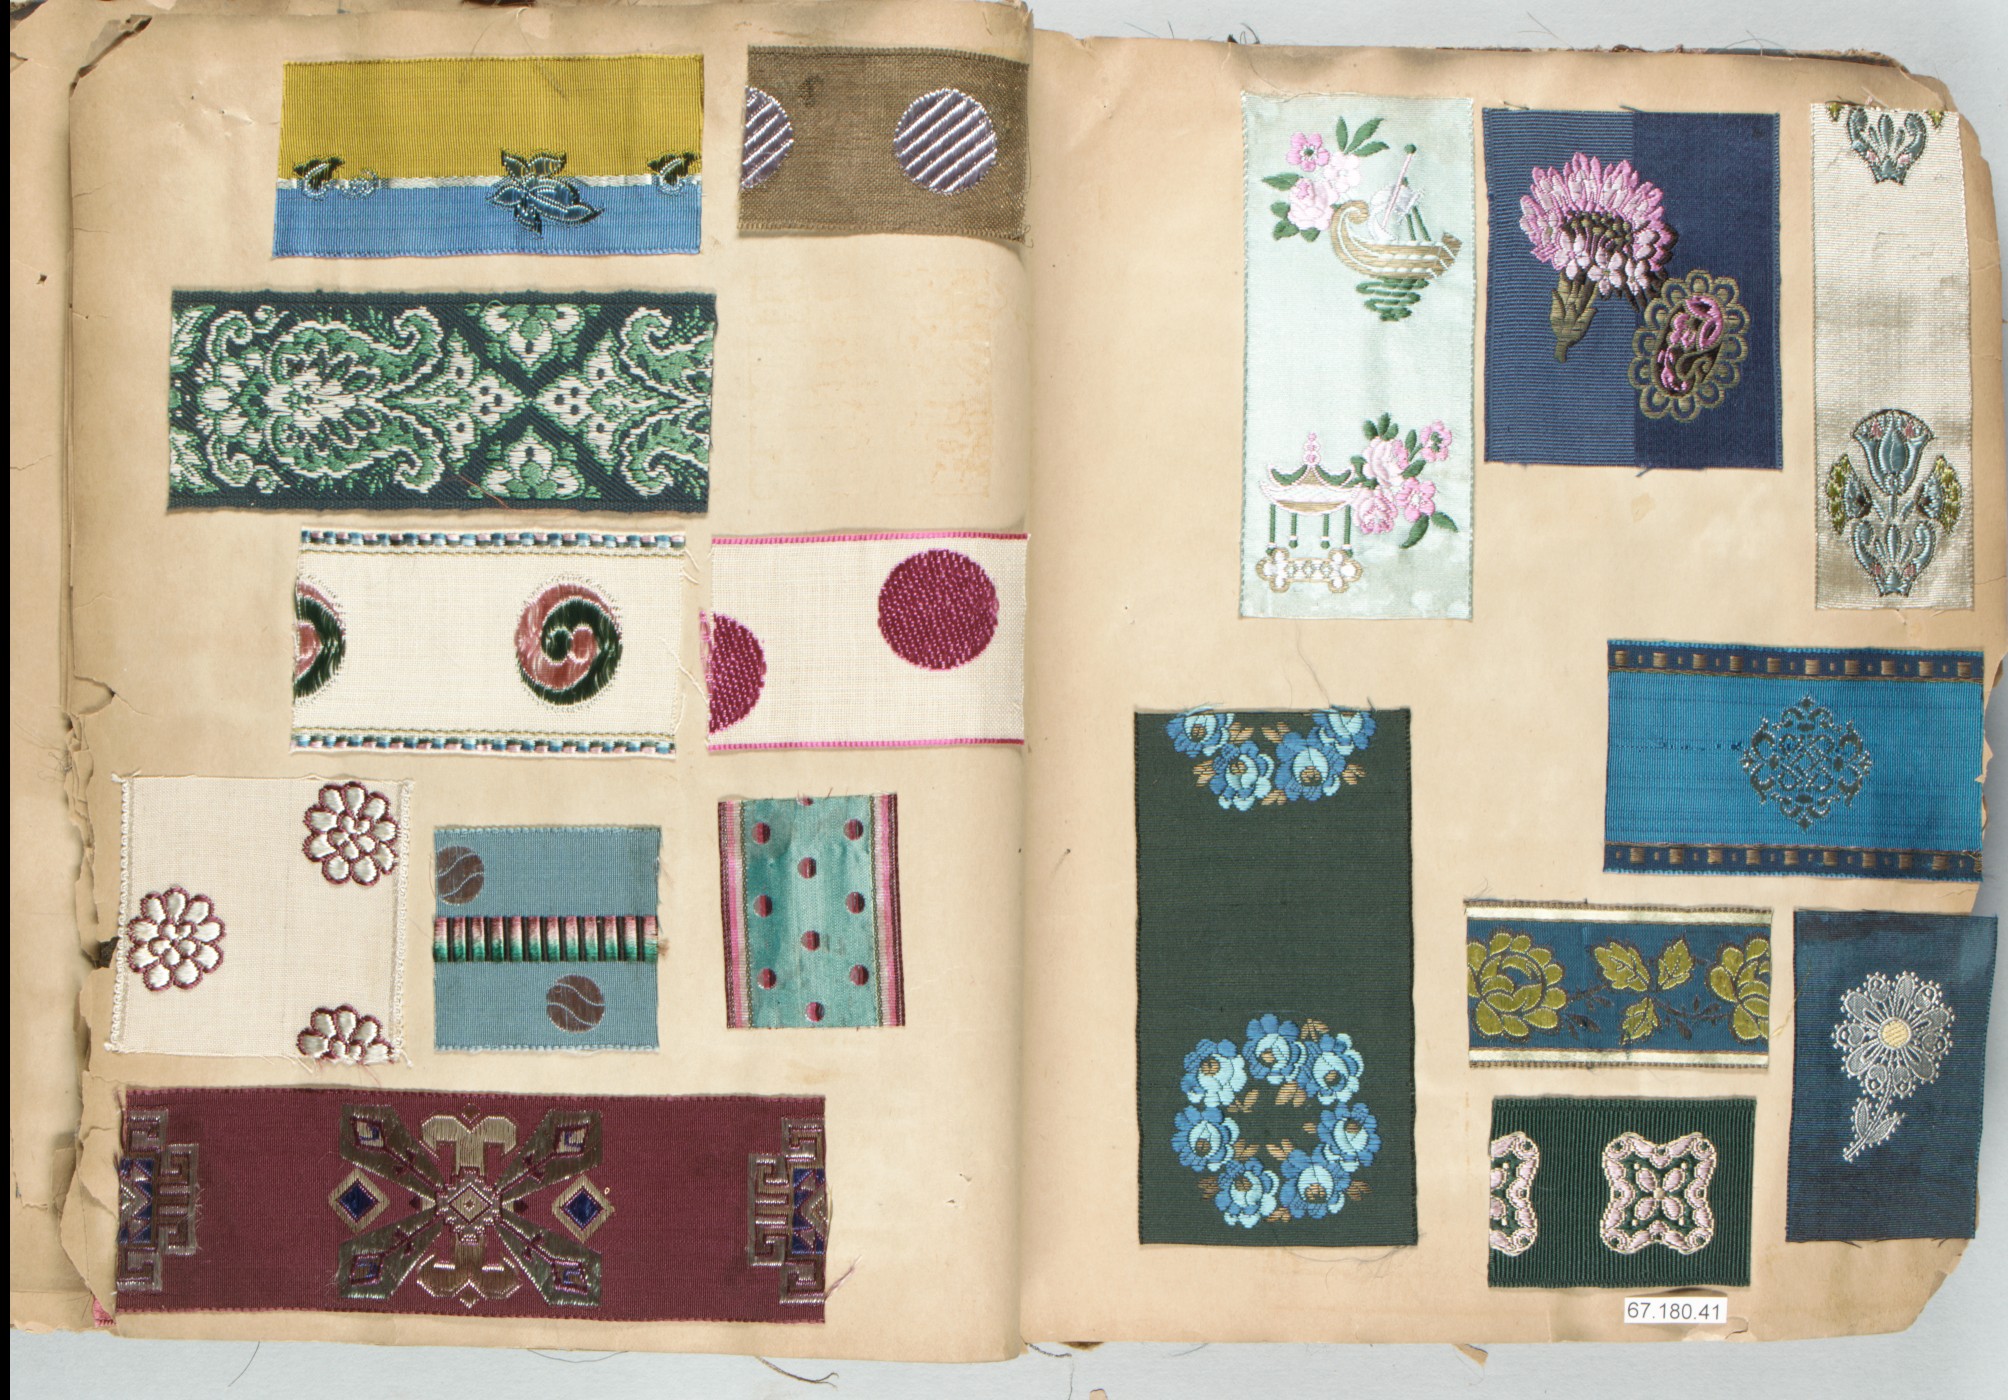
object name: sample book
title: Textile Sample Book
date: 1895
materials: silk